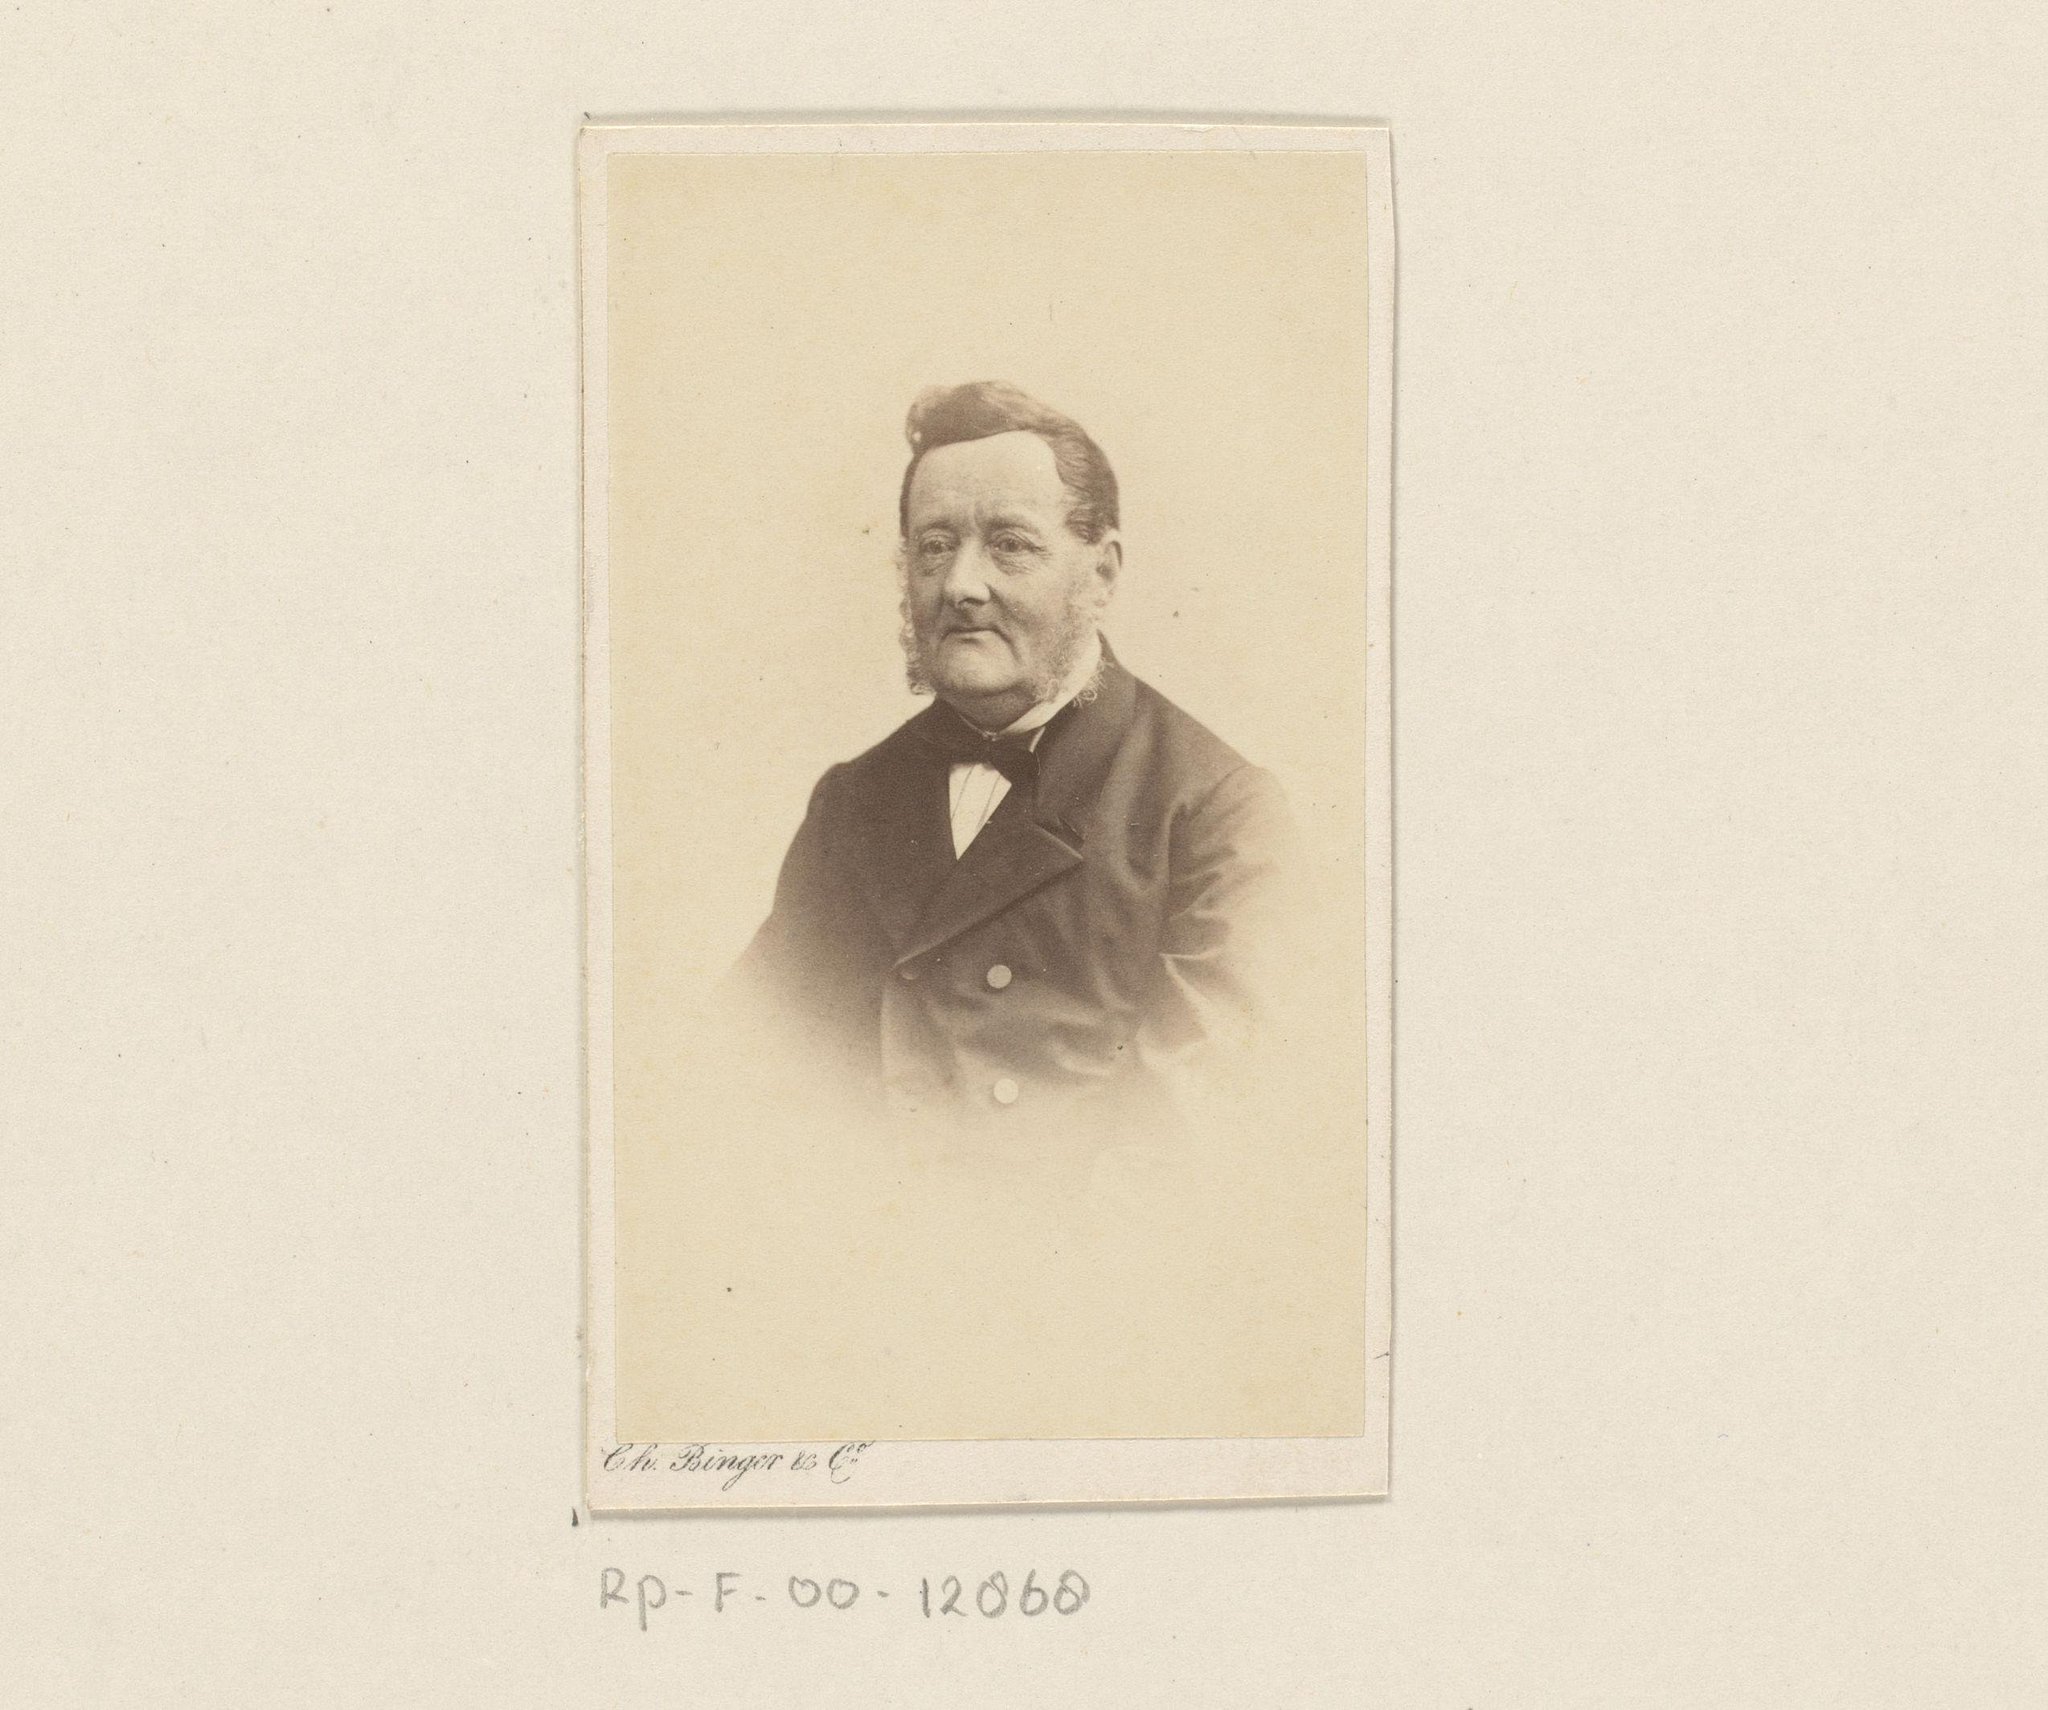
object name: photograph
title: Portret van H. Hinlopen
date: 1862-1882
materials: cardboard, paper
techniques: albumen print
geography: haarlem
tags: historical persons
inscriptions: inscription: ‘CHs BINGER & Cie/ Zylstraat, HAARLEM’